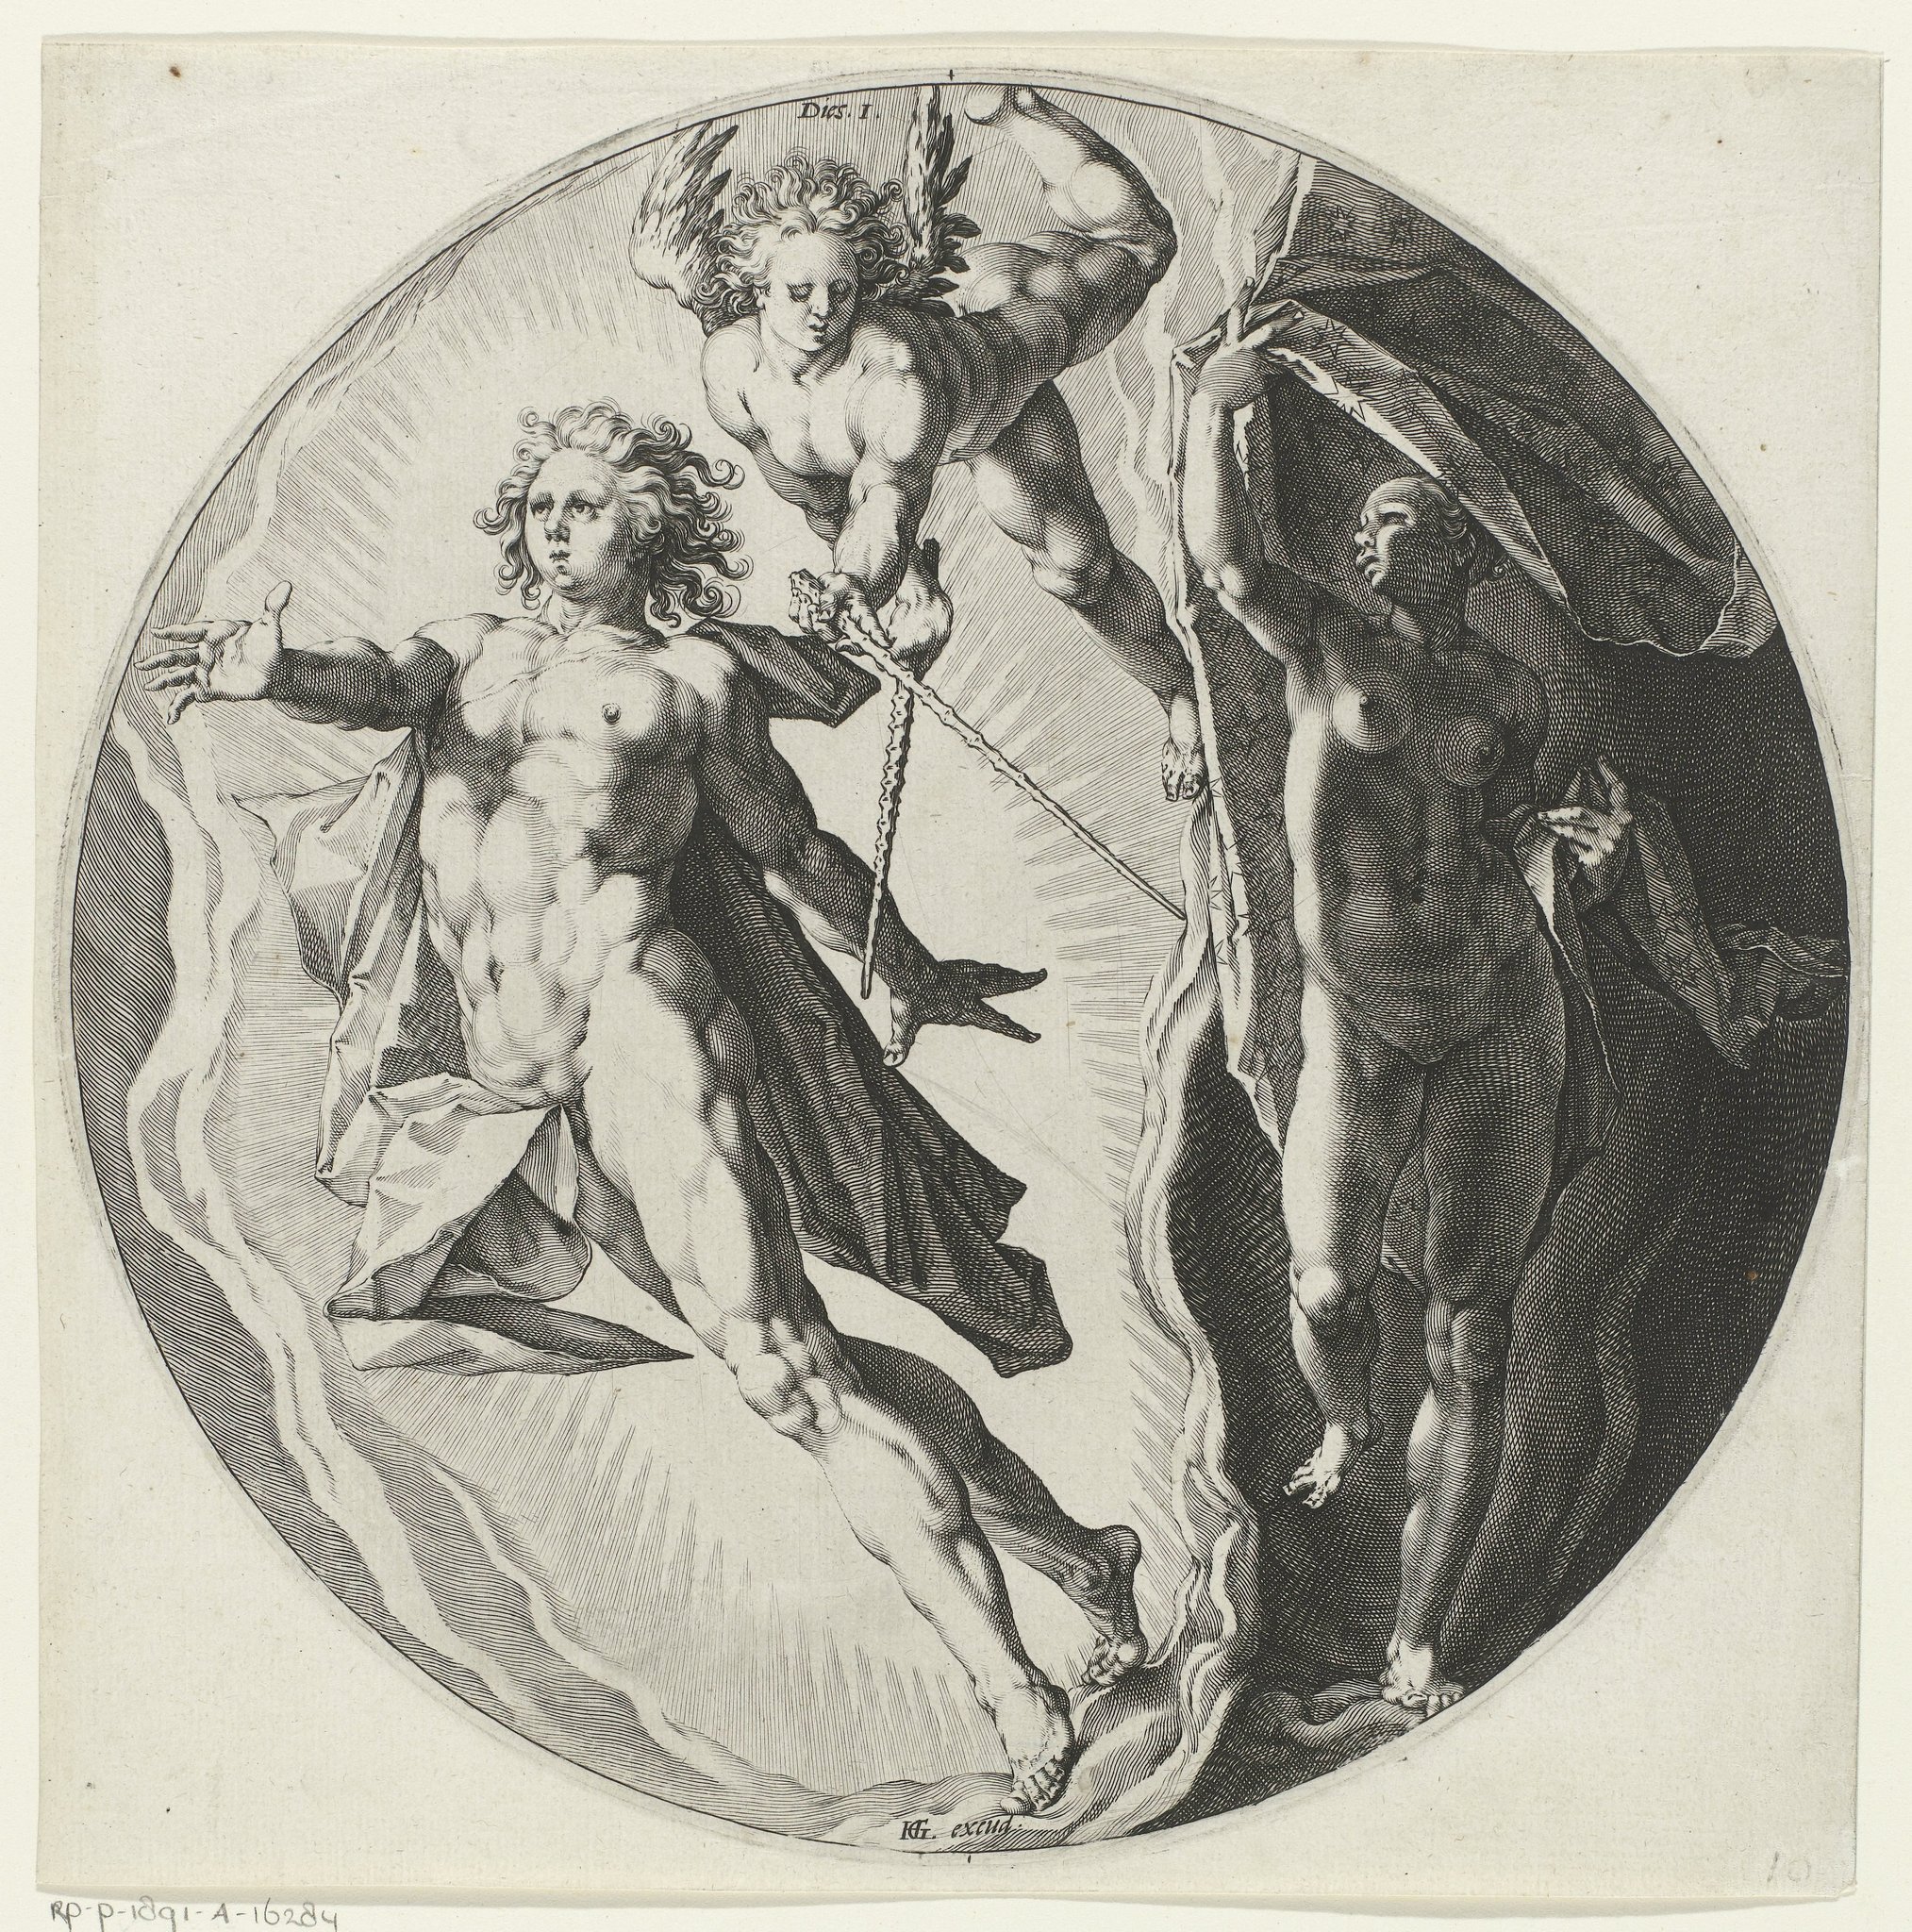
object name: print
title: Eerste scheppingsdag: scheiding van licht en duisternis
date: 1589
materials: paper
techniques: engraving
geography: amsterdam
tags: division of light and darkness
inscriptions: collector's mark: Lugt 2228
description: De eerste scheppingsdag: een engel scheidt het licht van het duister en dag van nacht. Het licht wordt voorgesteld als een naakte blanke jongeman in stralenkrans, het duister als een naakte zwarte vrouw met een sterrenmantel. Naar de Bijbeltekst in Gen. 1:3-5.